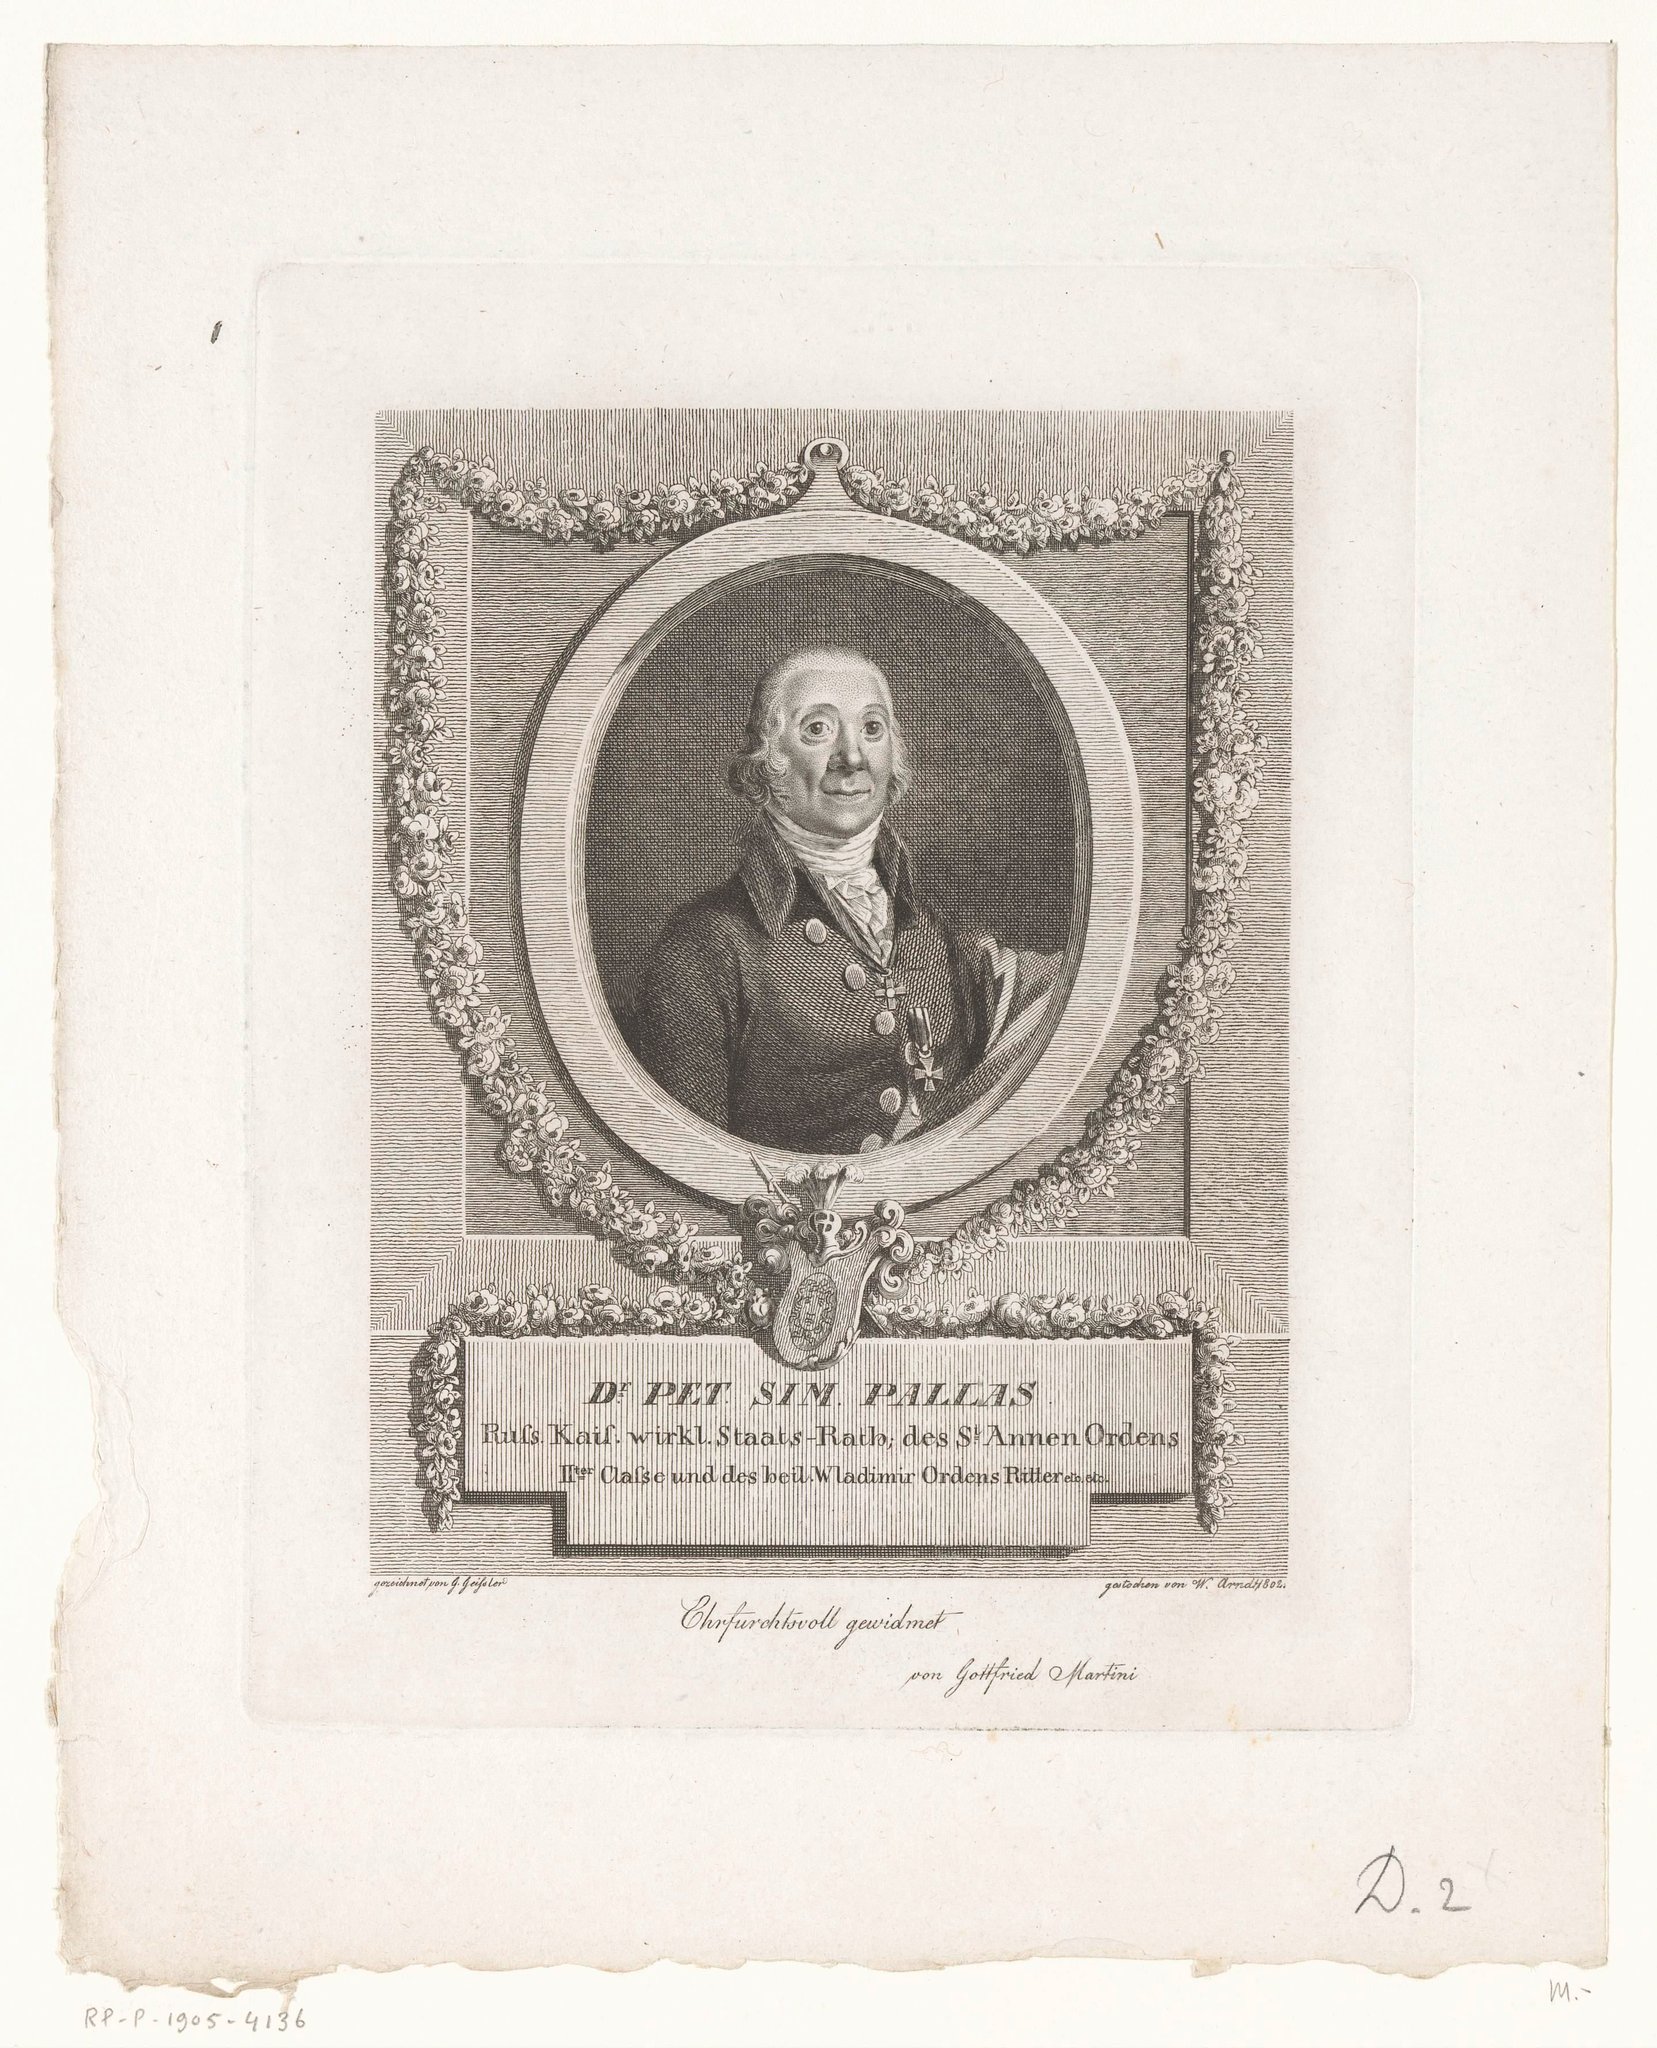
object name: print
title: Portret van Peter Simon Pallas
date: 1802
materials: paper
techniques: engraving, etching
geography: germany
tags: berlin, peter simon pallas, historical persons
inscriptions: collector's mark: Lugt 2228